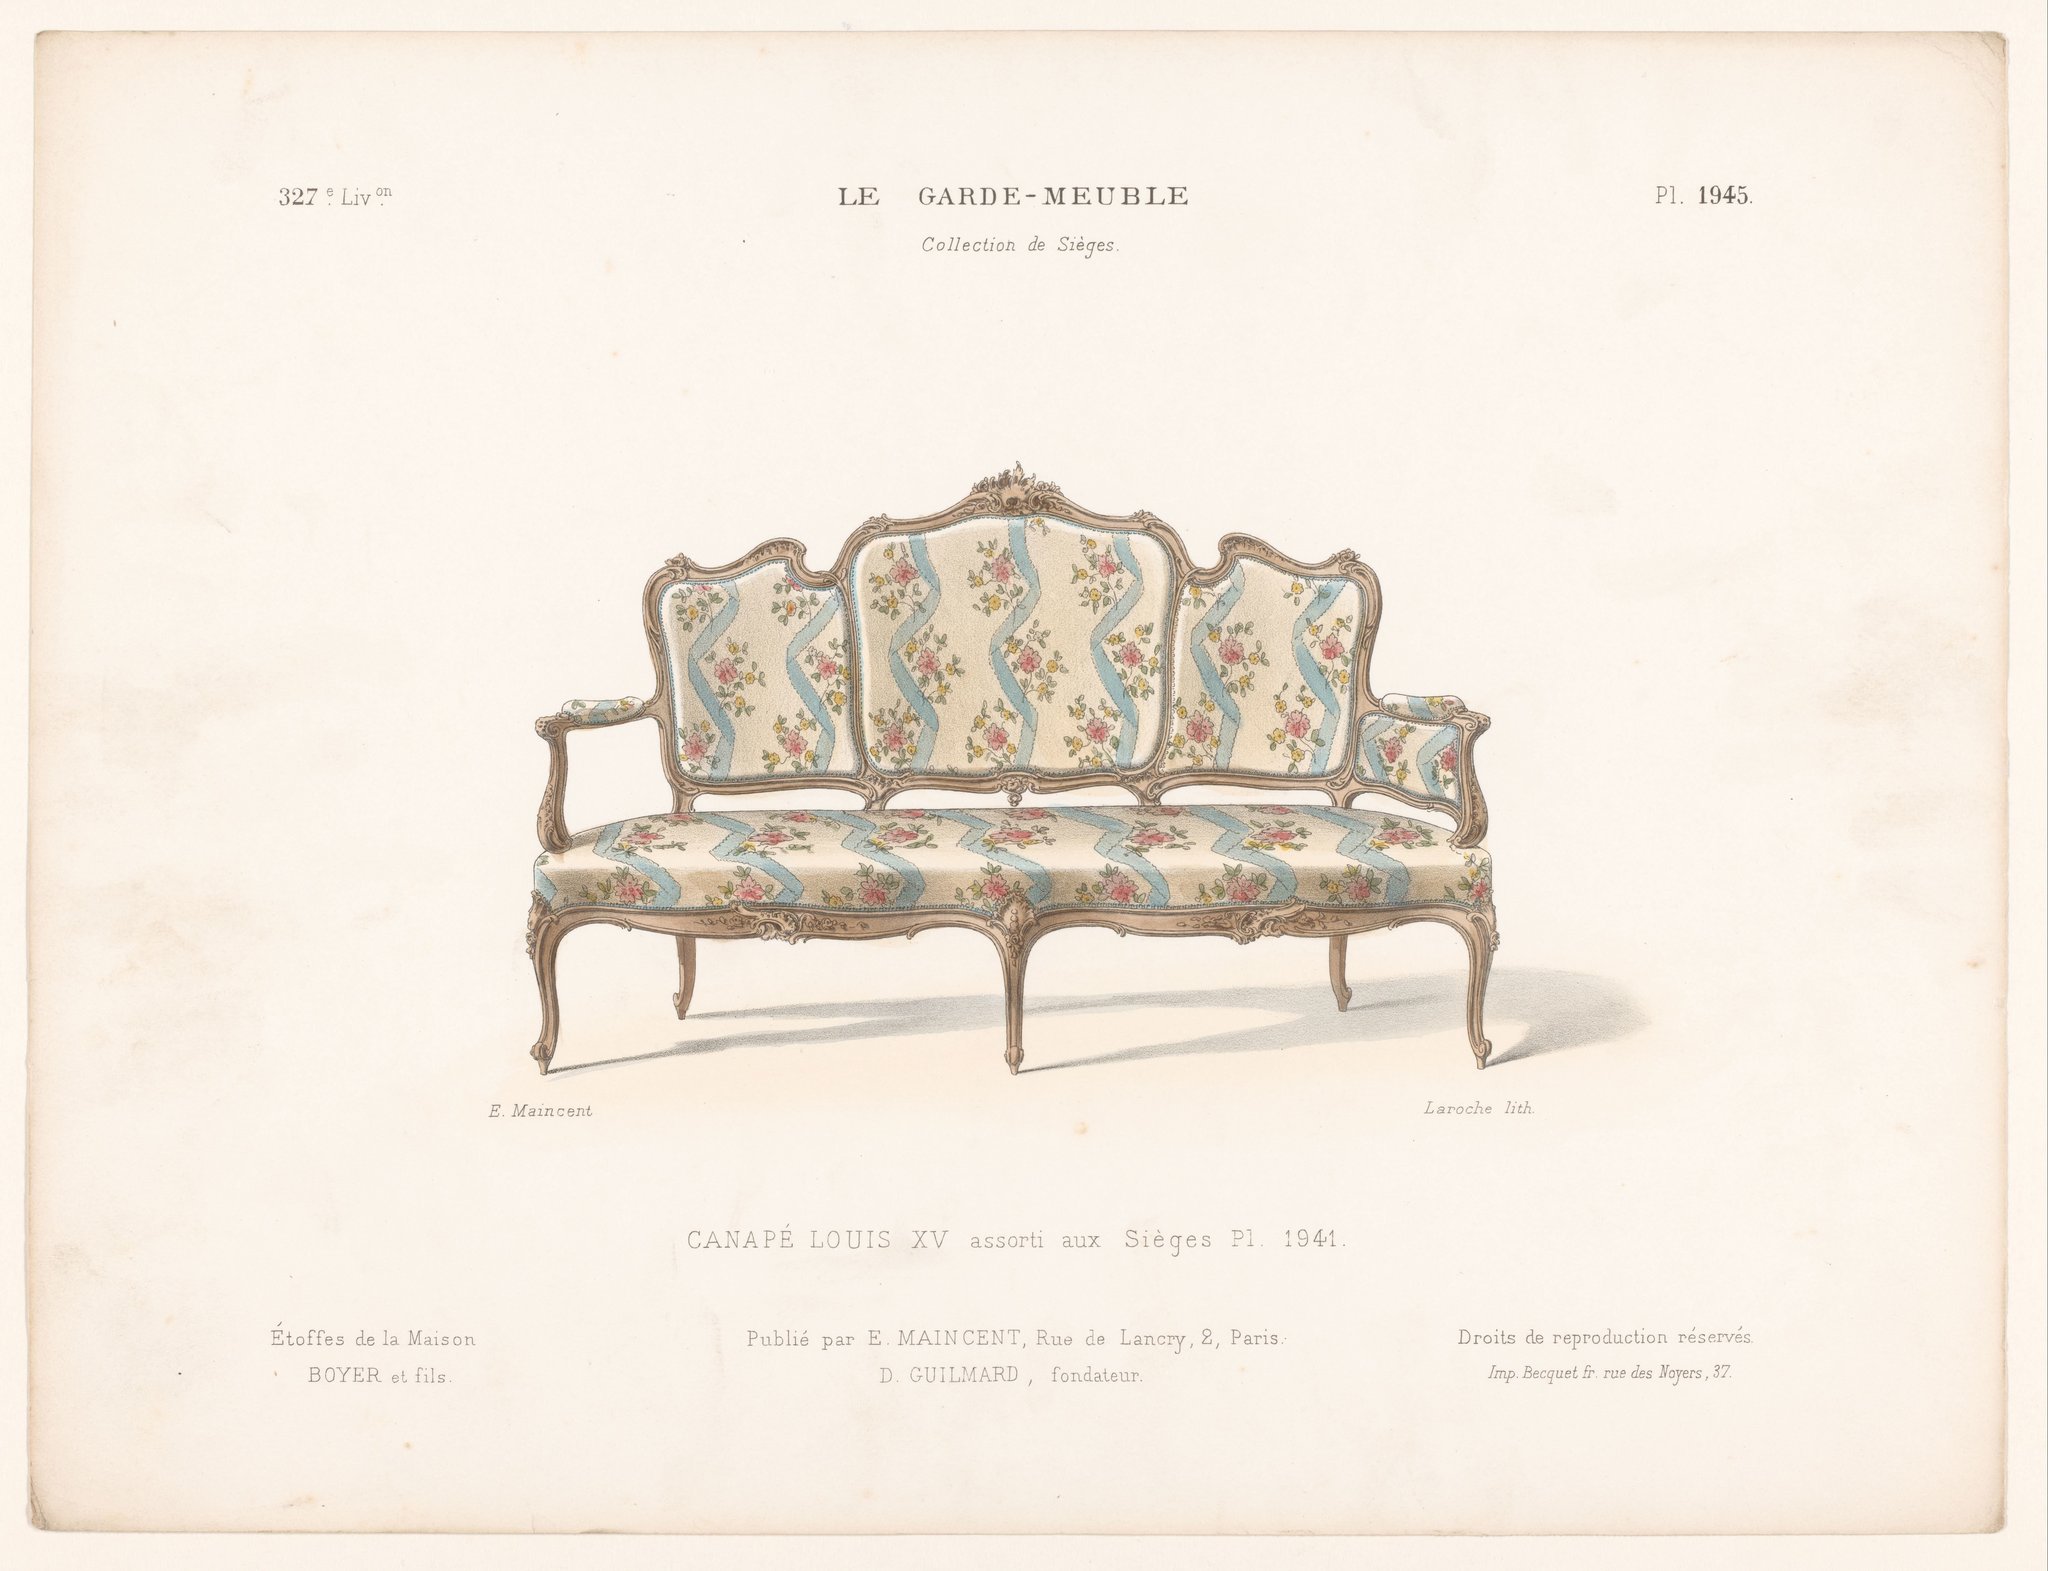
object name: print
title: Canapé Louis XV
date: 1885-1895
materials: paper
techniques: hand coloring, lithograph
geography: paris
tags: seating furniture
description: Ieder Livraison in de serie Le Garde-Meuble bevat negen platen: drie 'sièges' (zitmeubels), drie 'meubles' (diverse meubels zoals tafels en kasten) en drie 'tentures' (gordijnen en draperieën).